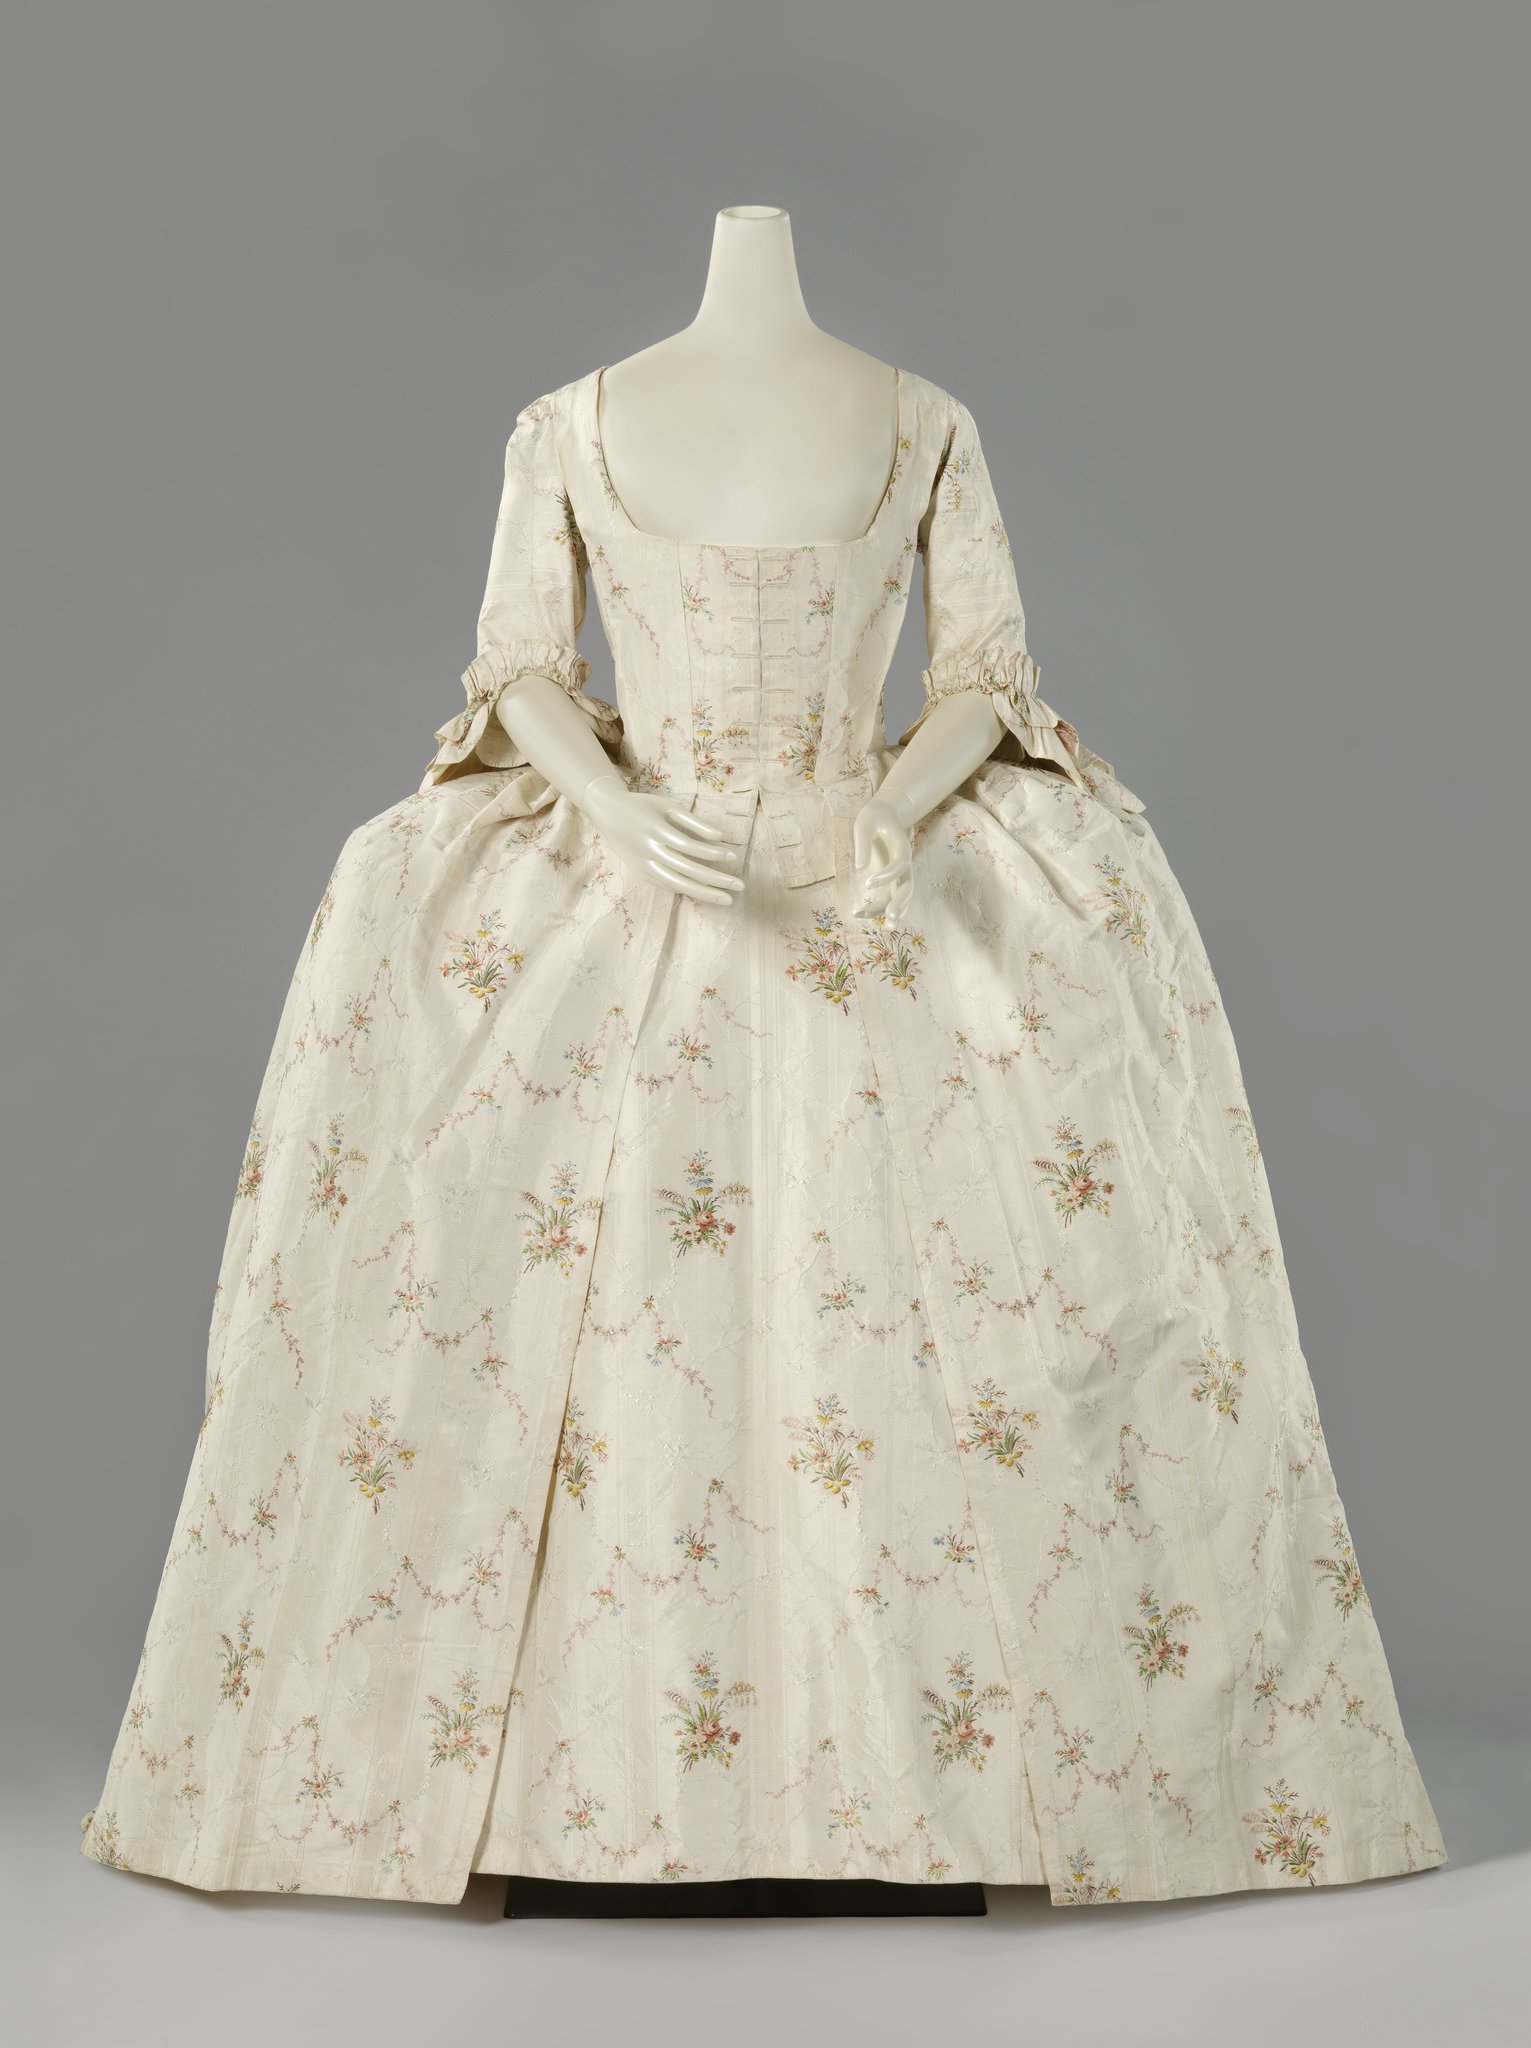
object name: womenswear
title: Japon van crèmekleurige zijde met ingeweven strepen, bloemenranken en kettingmotief en meerkleurig geborduurd met boeketten en guirlandes; overjapon, rok, panier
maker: Anonymous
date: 1750-1800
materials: linen, silk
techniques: embroidered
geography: netherlands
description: Japon van gebloemde crème-kleurige zijde met ingeweven boeketten en guirlandes in verschillende kleuren; bestaande uit een manteau (a) en een rok (b). Bijbehorend een panier (c).